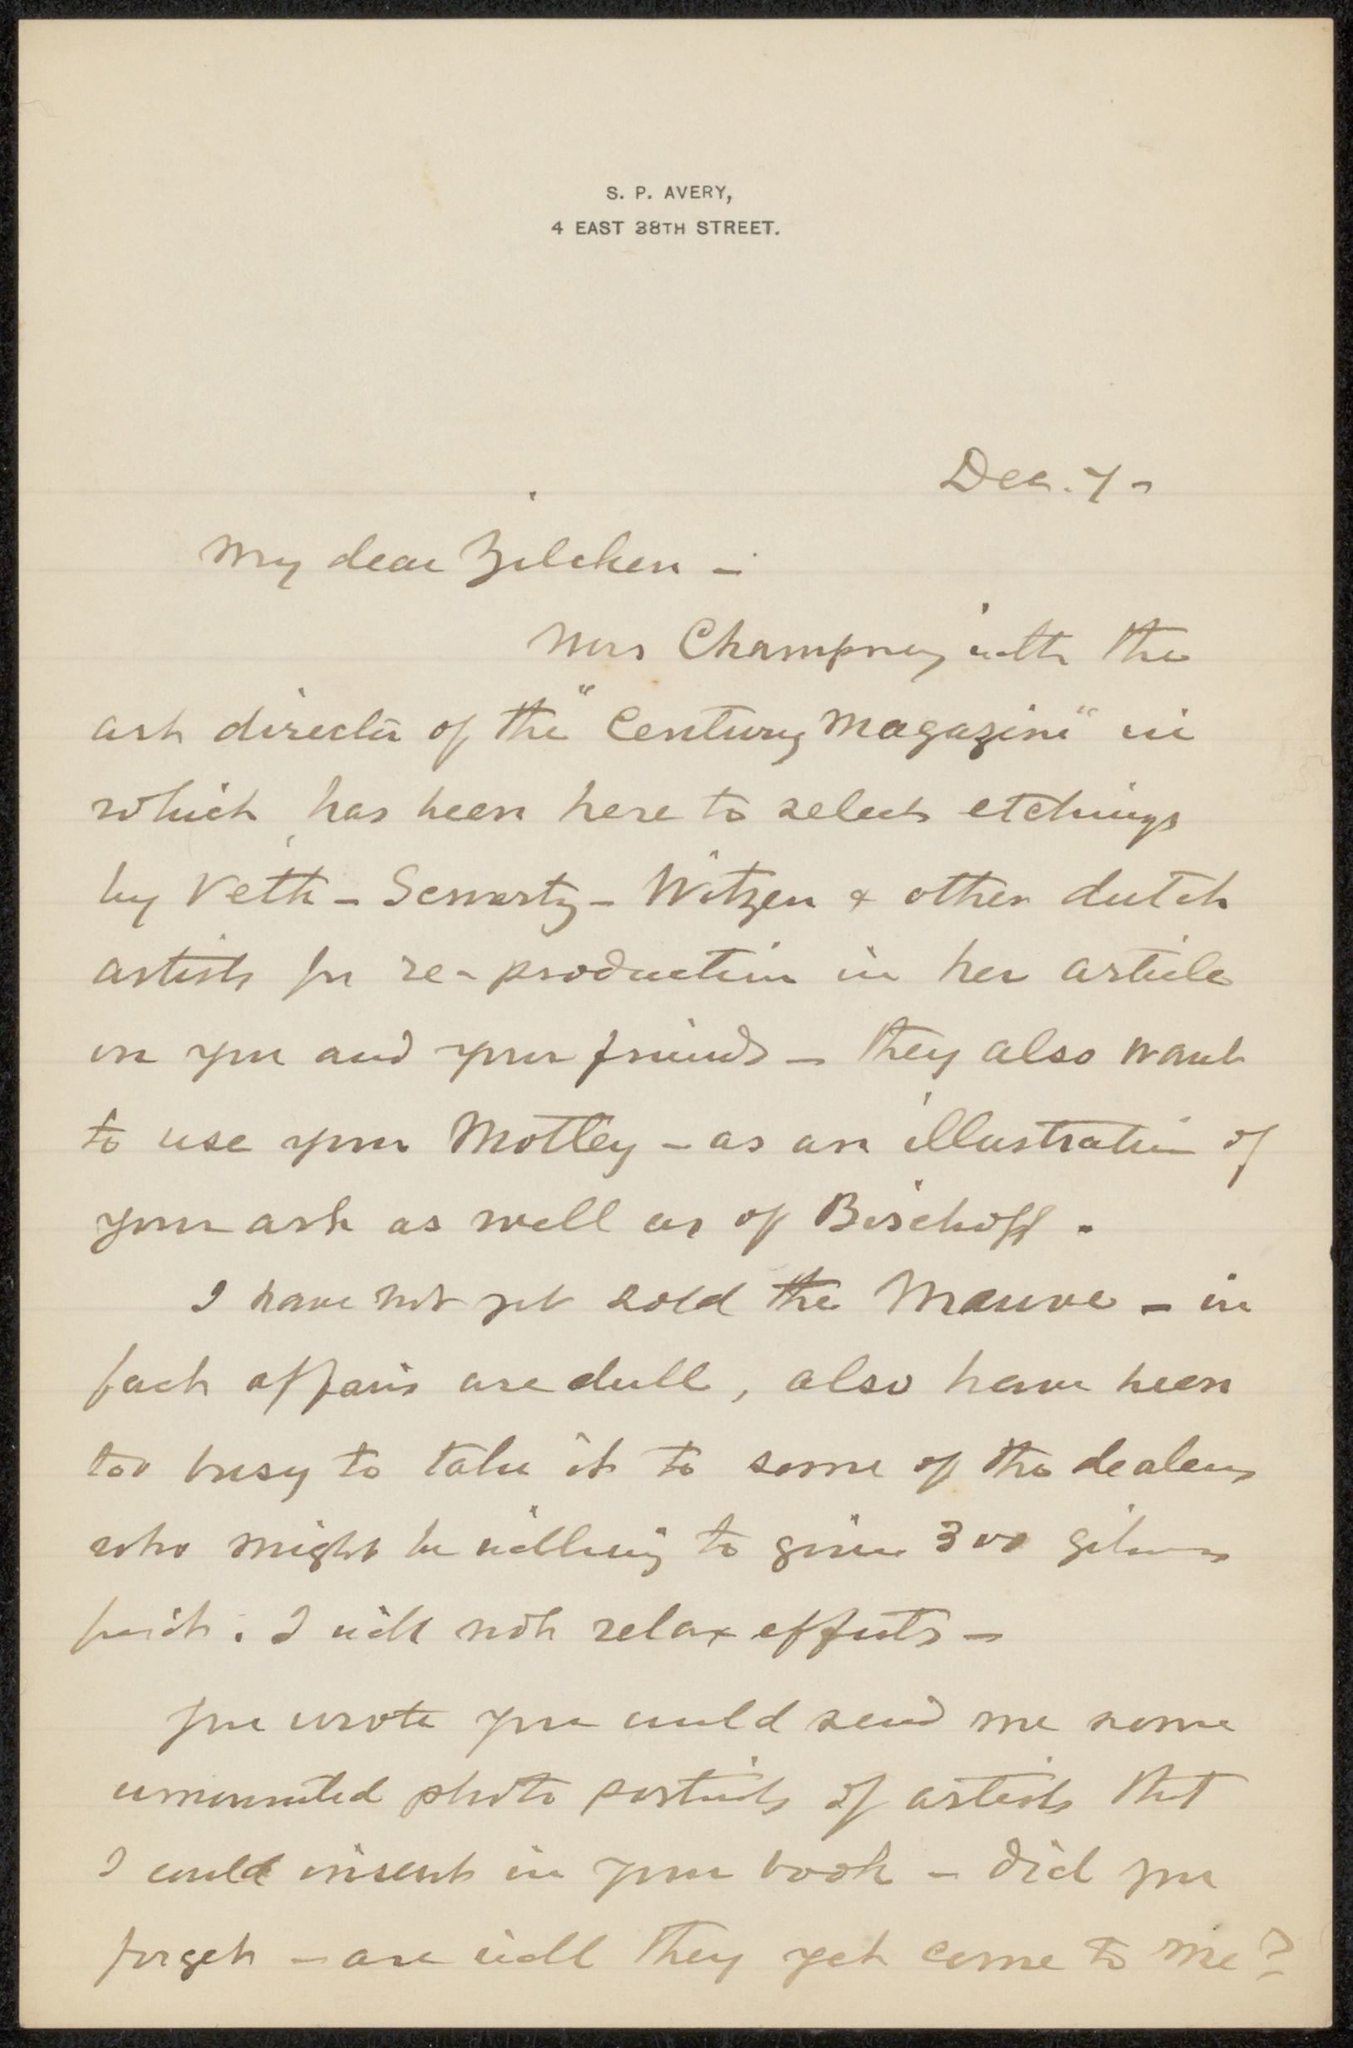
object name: letter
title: Brief aan Philip Zilcken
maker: samuel putnam avery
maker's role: verzamelaar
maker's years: 1822-1904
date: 1832-1904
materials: ink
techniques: pen, printing, writing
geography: new york city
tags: thérèse schwartze, dordrecht, amsterdam, painter, print maker, draughtsman, designer, jan veth, anton mauve, willem witsen, elizabeth williams champney, philip zilcken, art trade, art shop, the graphic arts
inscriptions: collector's mark: ‘RPK’